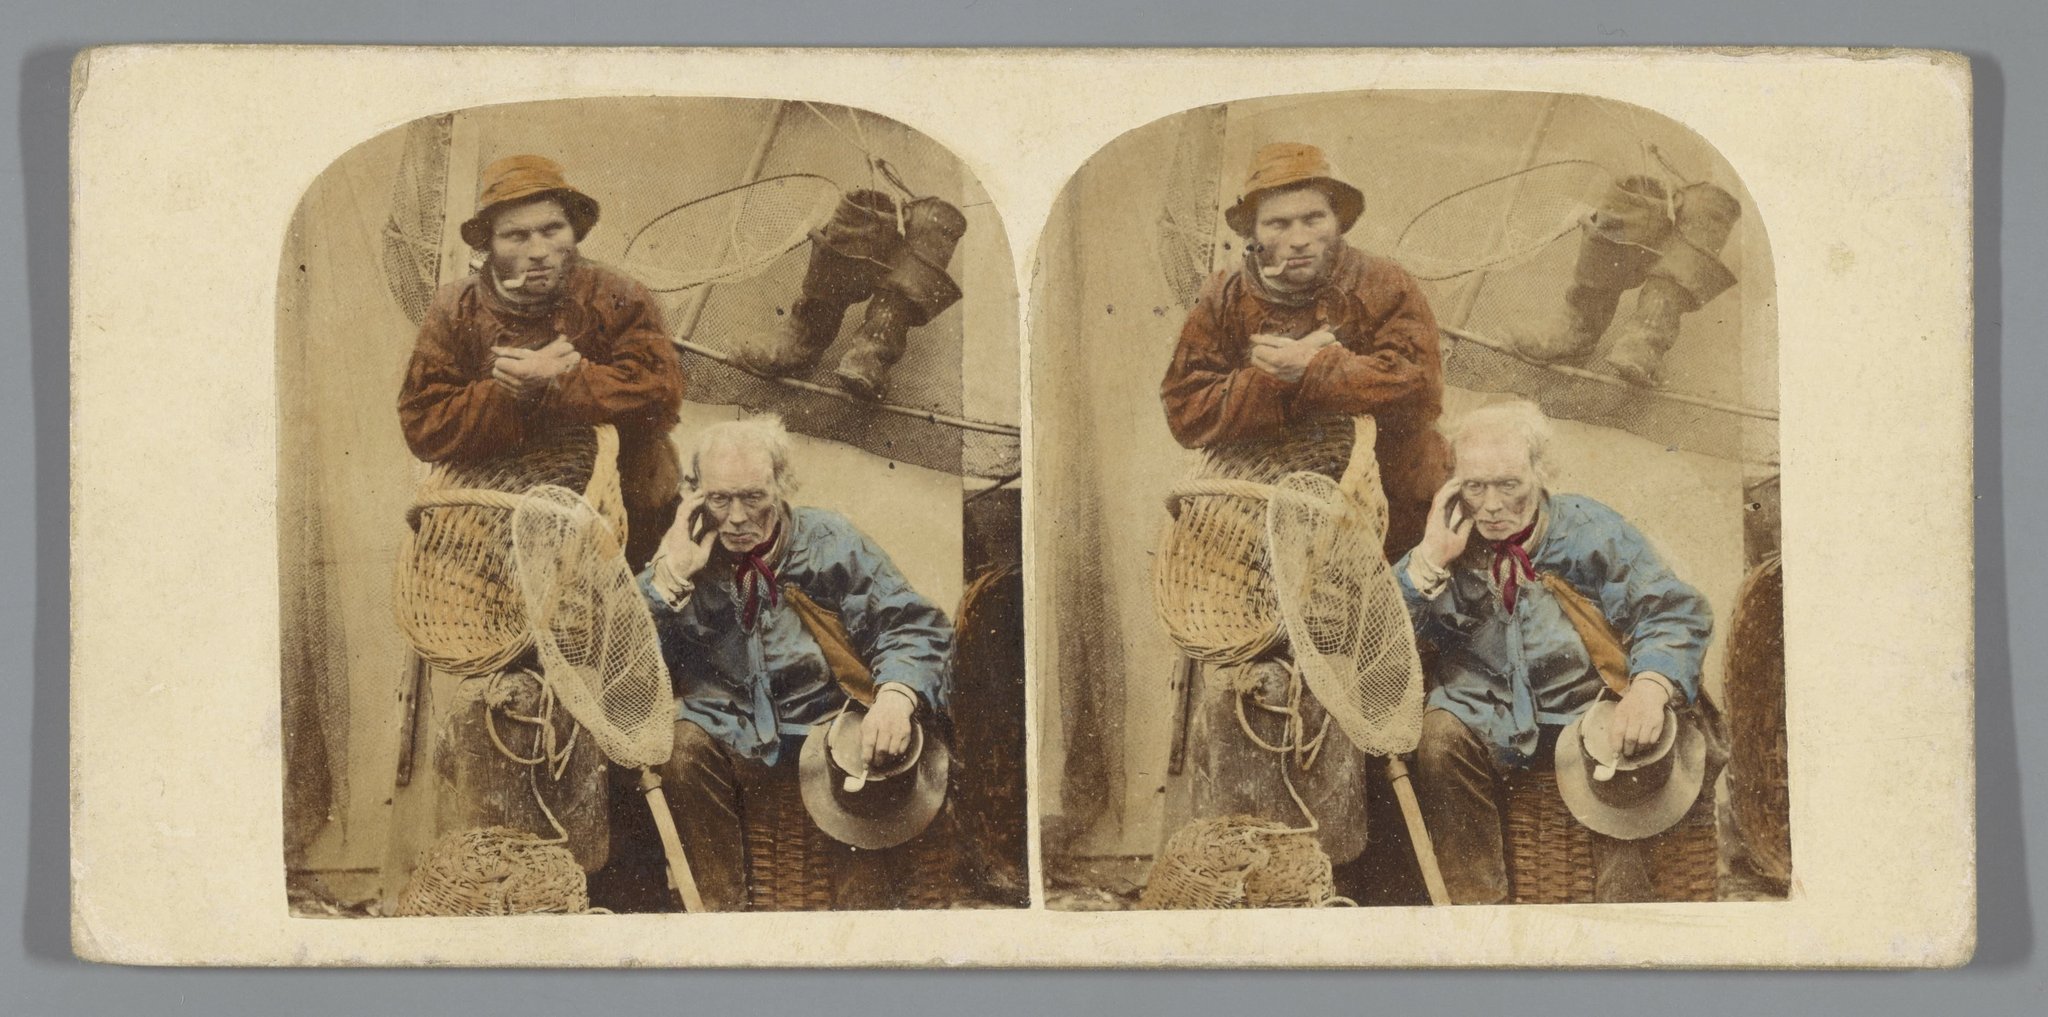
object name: stereograph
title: Brighton Fishermen, Waiting for the Tide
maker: Anonymous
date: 1852-1863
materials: cardboard, paper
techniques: albumen print, hand coloring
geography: brighton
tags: fisherman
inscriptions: retailer's mark: ‘Nolet & Zoon/ Utrecht’